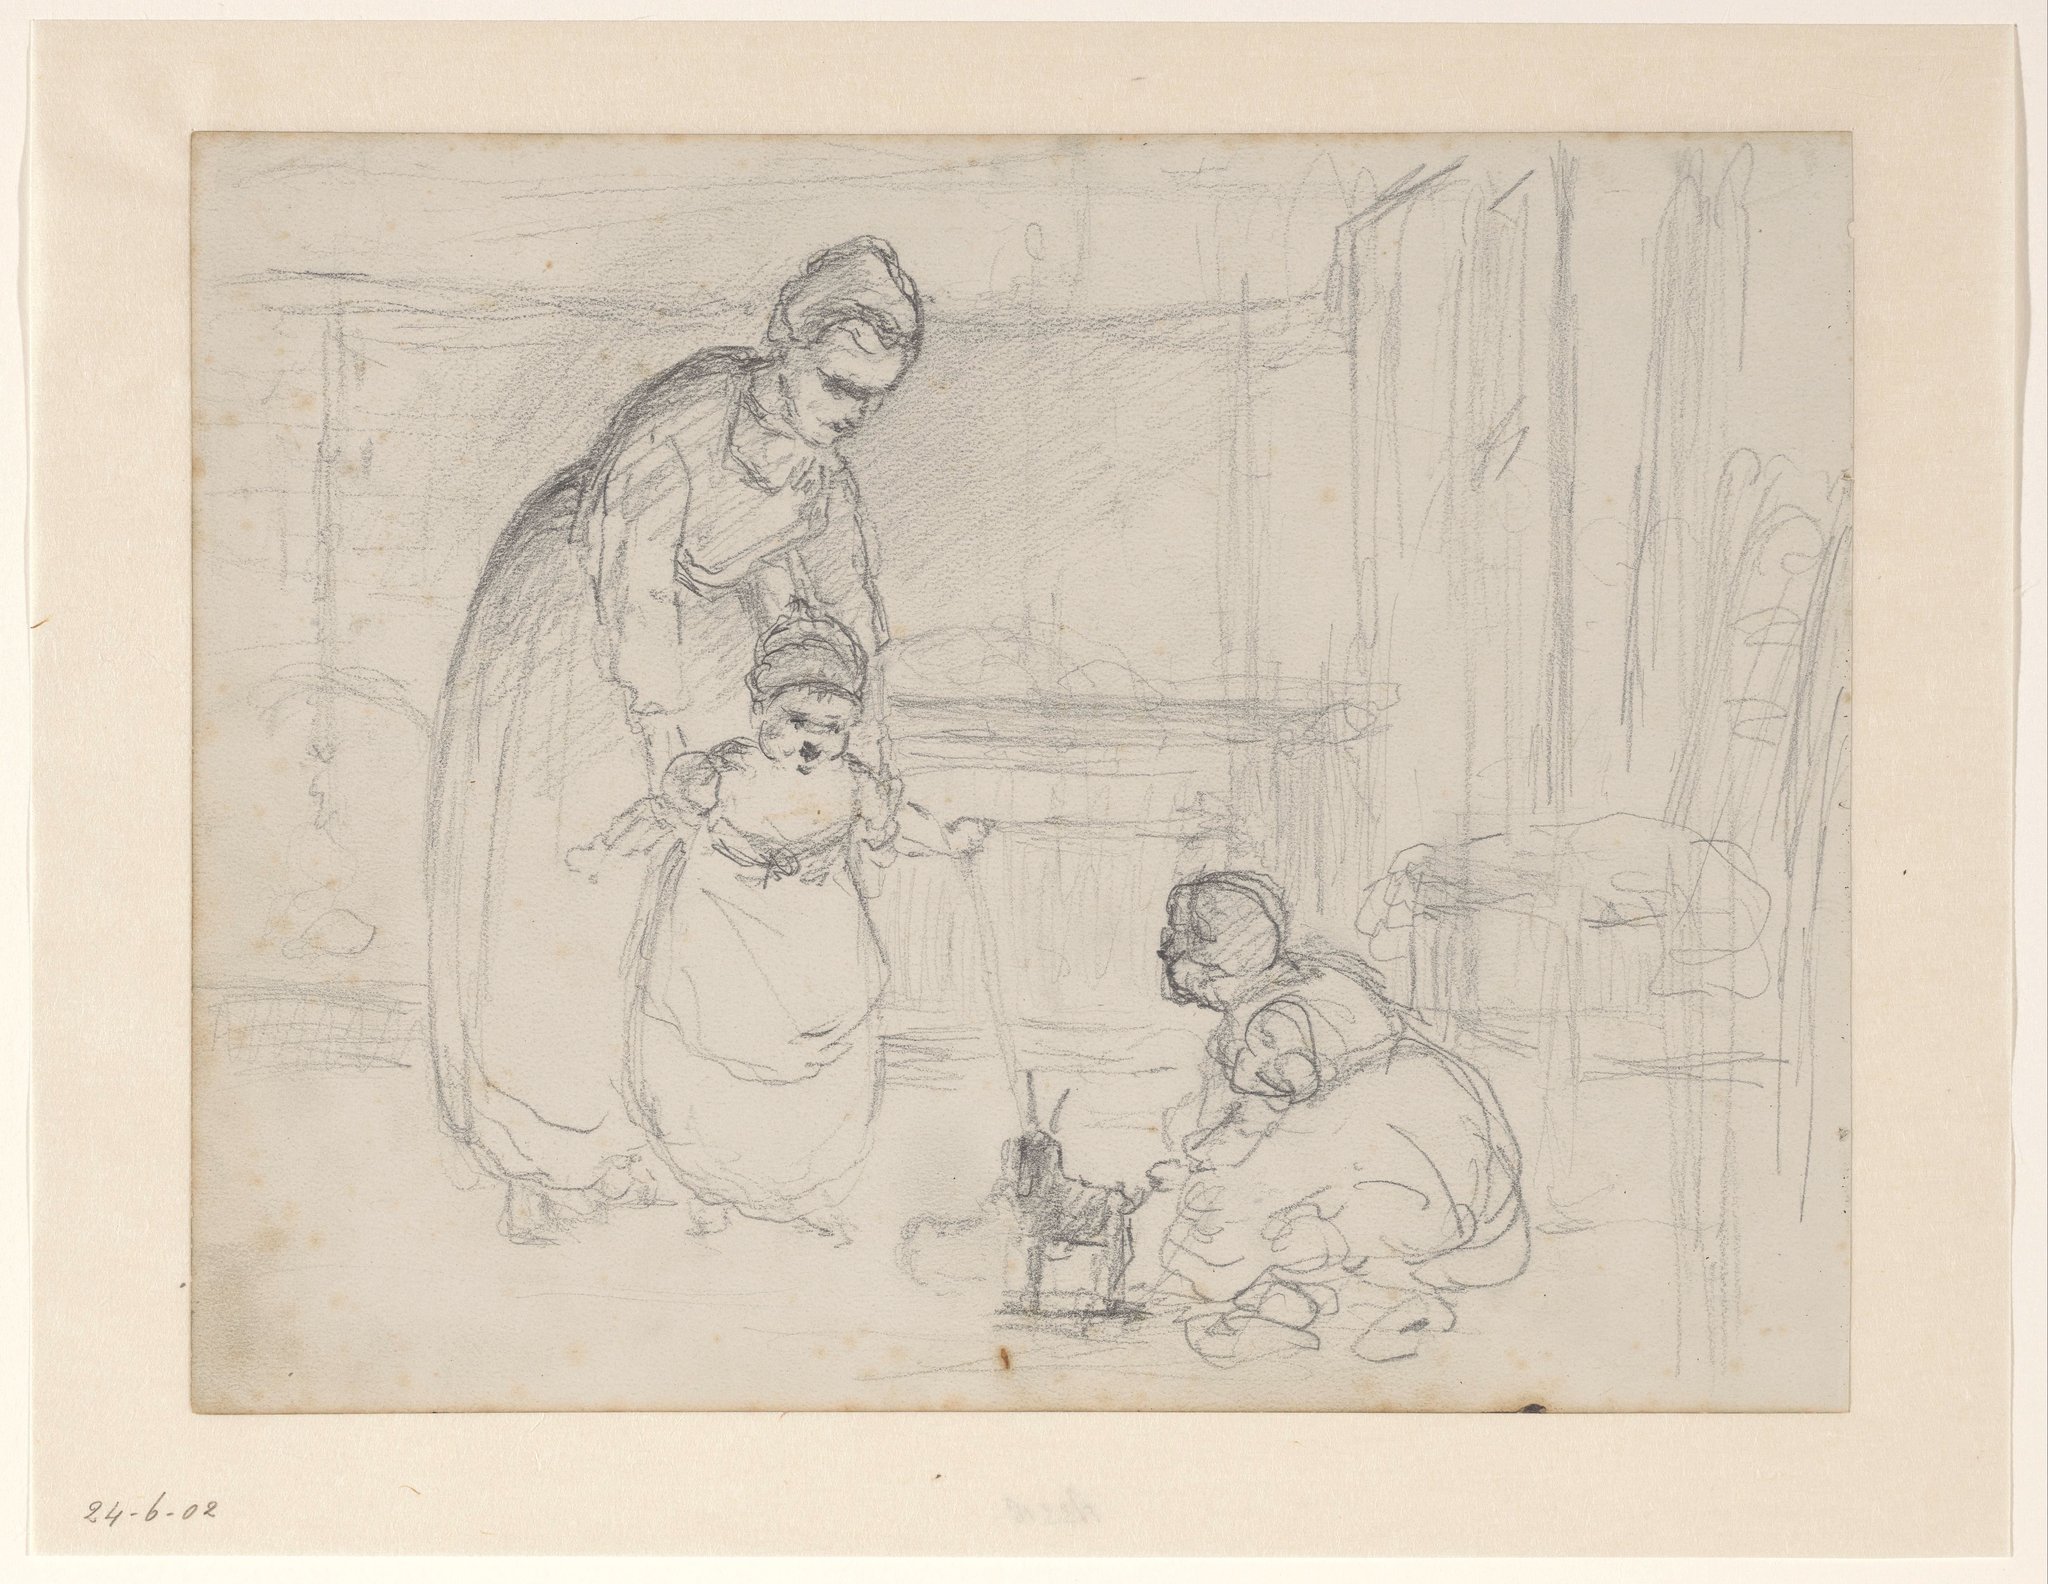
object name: drawing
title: Interieur met vrouw en twee kleine kinderen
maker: hendrik valkenburg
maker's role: draughtsman, painter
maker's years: 1826-1896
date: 1836-1896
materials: chalk, paper, pencil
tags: family life, interior of the house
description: Interieur met vrouw en twee kleine kinderen. Verso: twee maal een interieur met vrouwen en een baby.